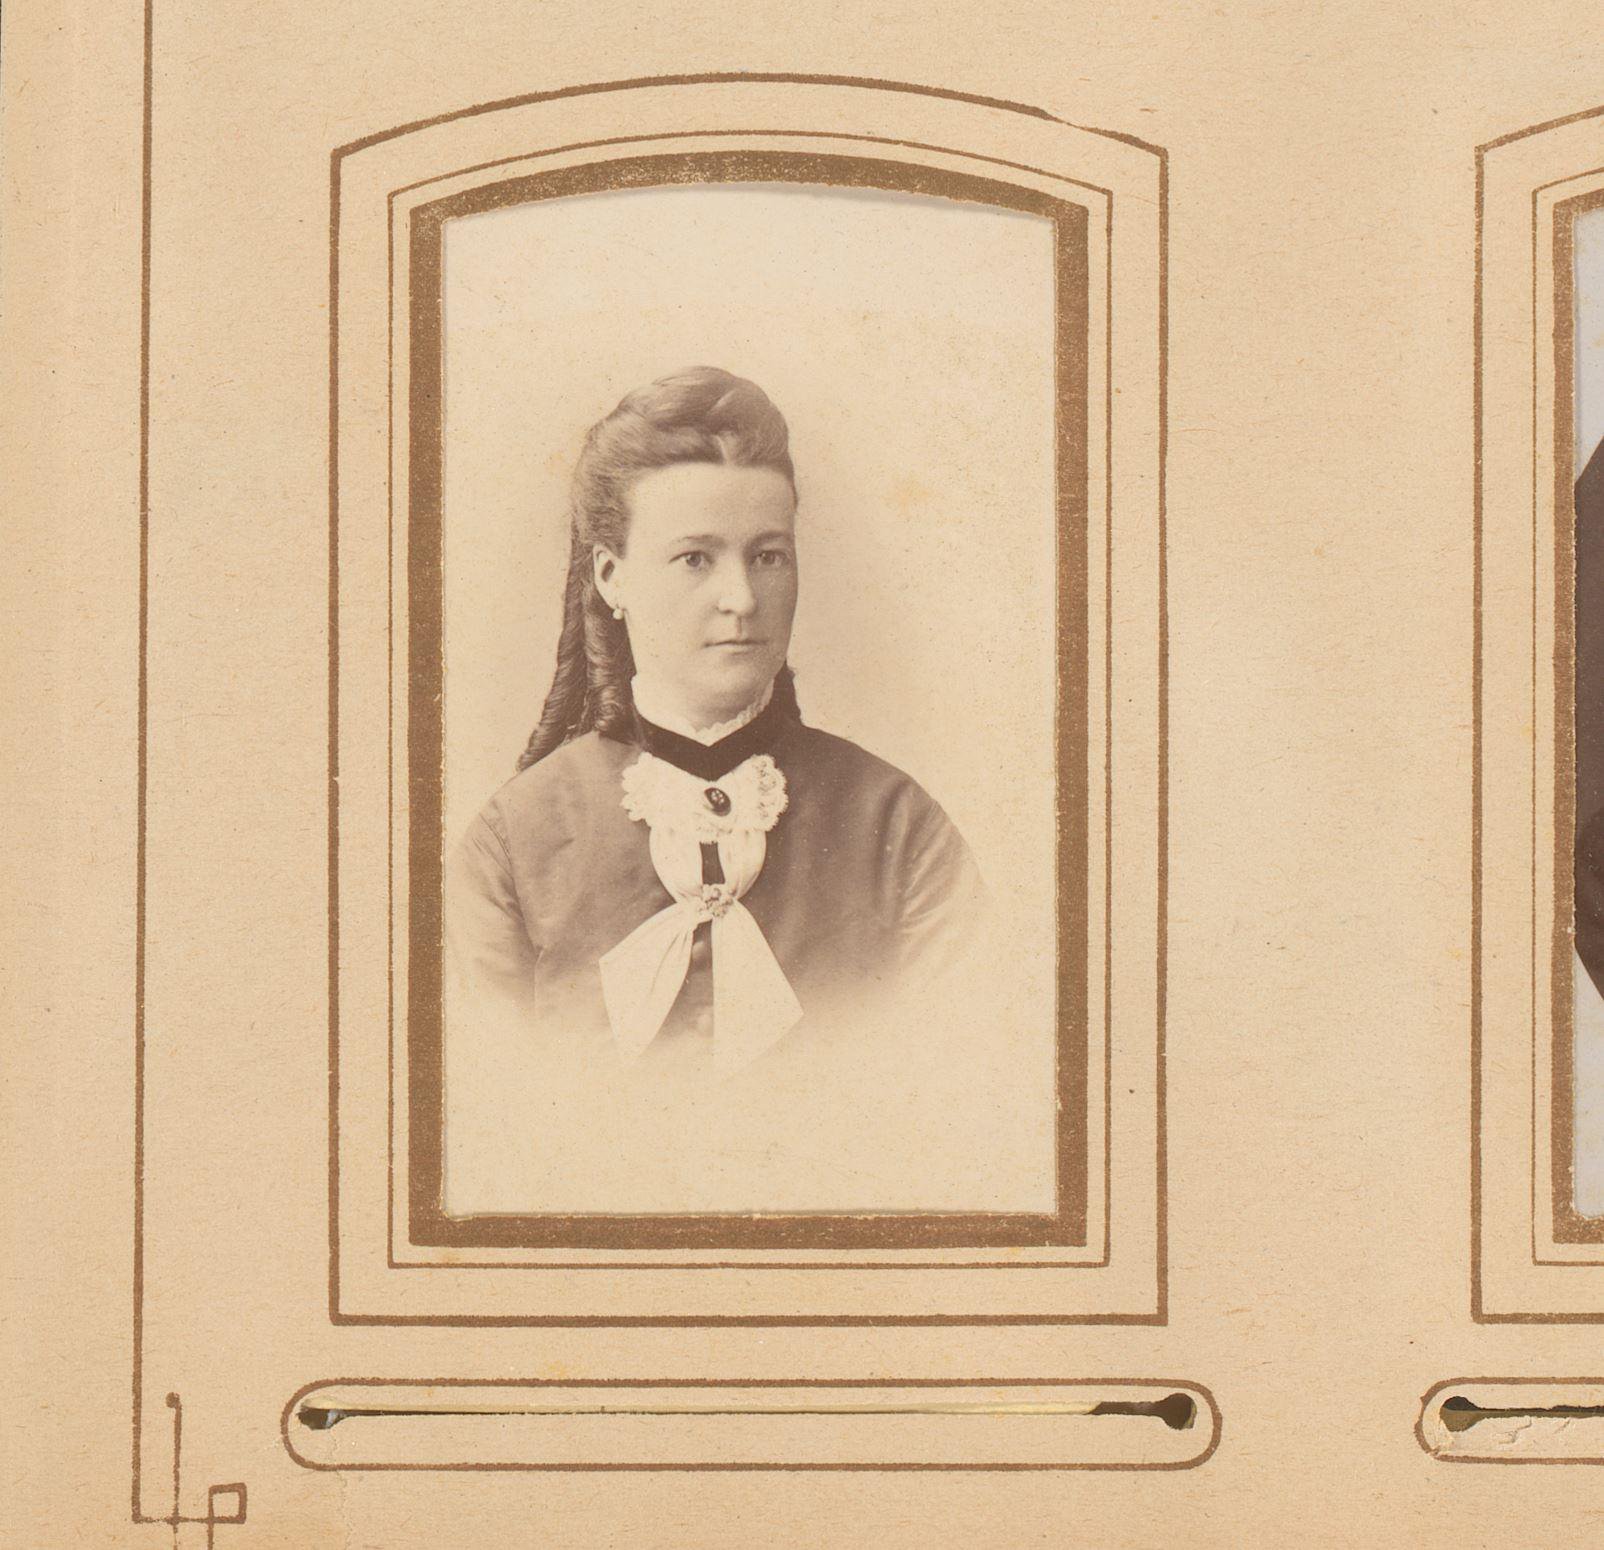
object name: carte de visite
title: Portret van een vrouw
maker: bernardus bruining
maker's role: fotograaf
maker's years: 1834-1900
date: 1860-1900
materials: cardboard, photographic support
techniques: albumen print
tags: adult woman, historical persons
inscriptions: inscription: ‘B. Bruining/ Photographe/ van/ Z.K.H. Prins Frederik/ Der Nederlanden/ te/ Leiden(...)’